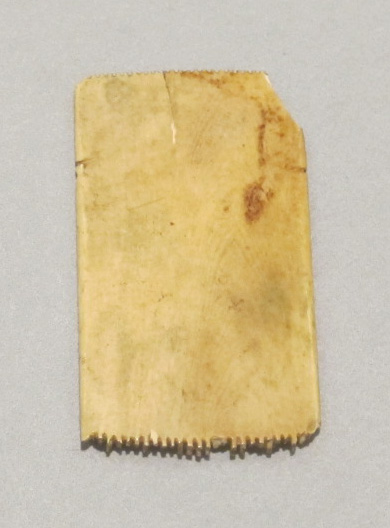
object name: comb fragment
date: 1550-1295 BCE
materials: ivory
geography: egypt